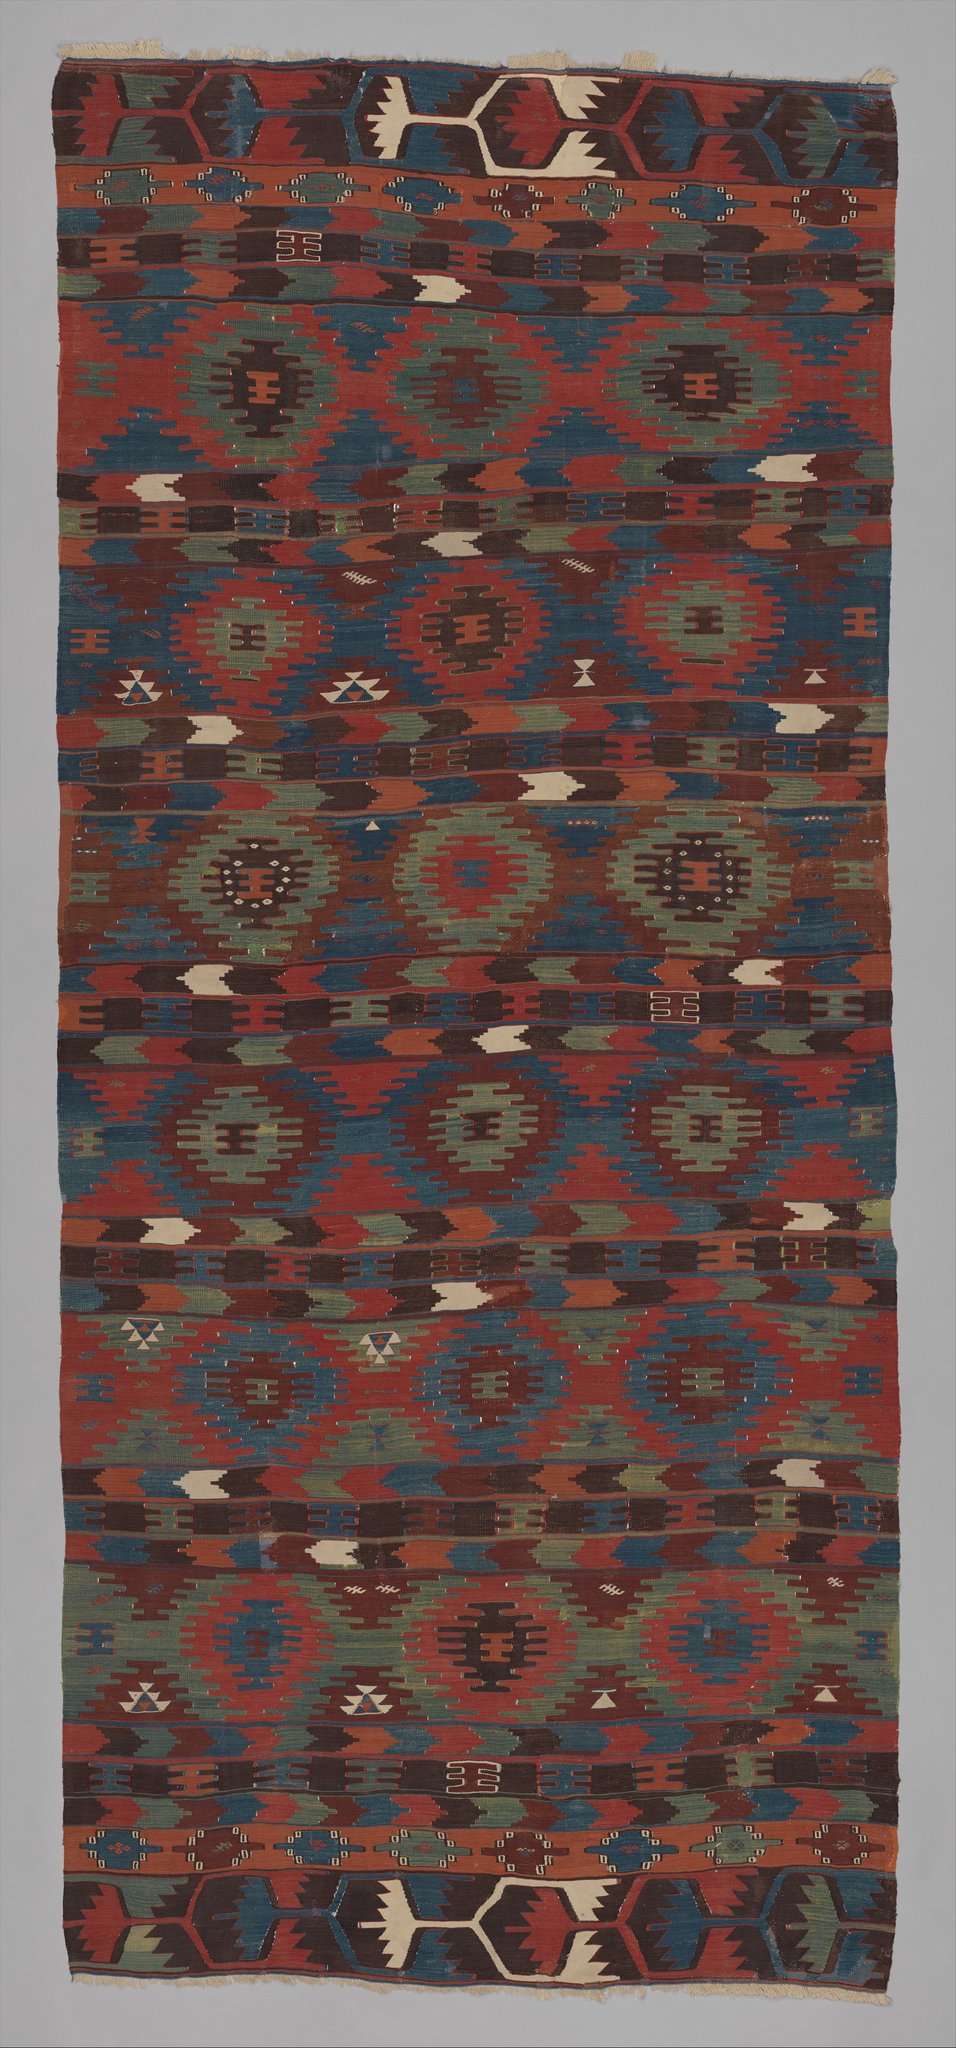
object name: carpet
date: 1801-1850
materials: cotton, wool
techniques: tapestry, weave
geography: turkey